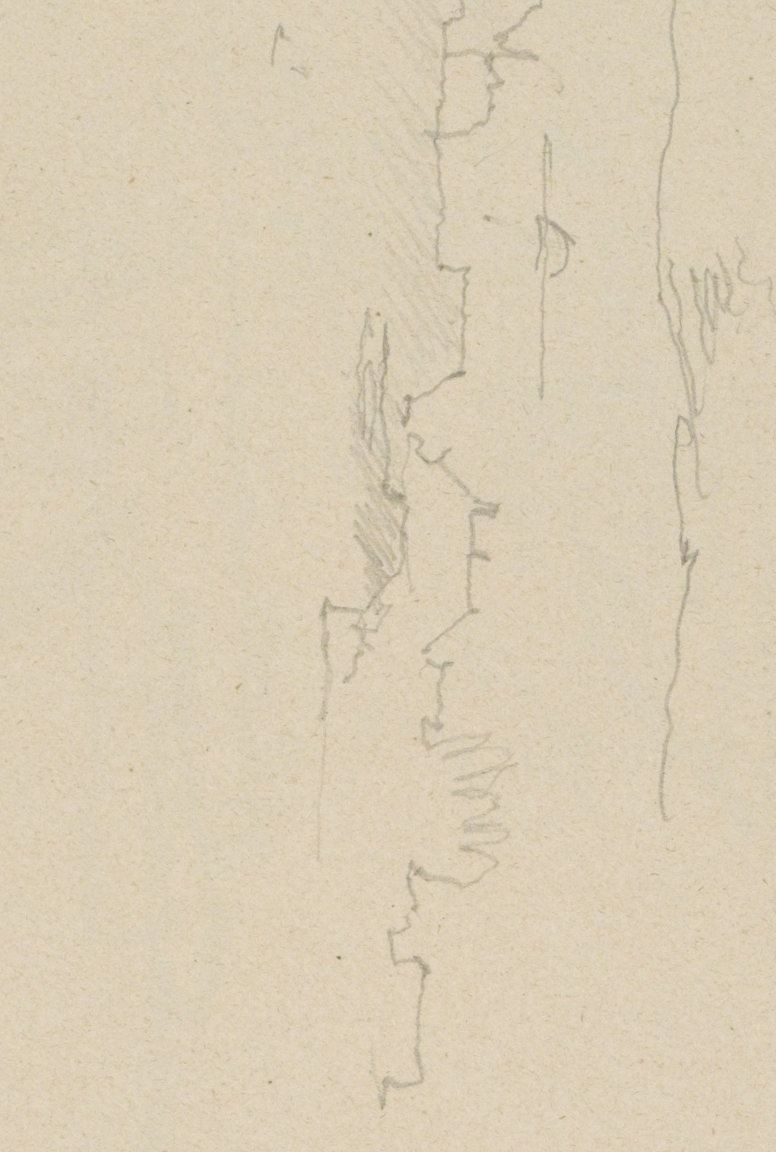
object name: sketchbook leaf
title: Stadsgezicht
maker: george hendrik breitner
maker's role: draughtsman, painter, print maker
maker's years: 1857-1923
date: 1914-1923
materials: paper, pencil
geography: north holland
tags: city-view, and landscape with man-made constructions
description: Stadsgezicht. Pagina 86 uit een schetsboek met 43 bladen vervaardigd te Amsterdam.